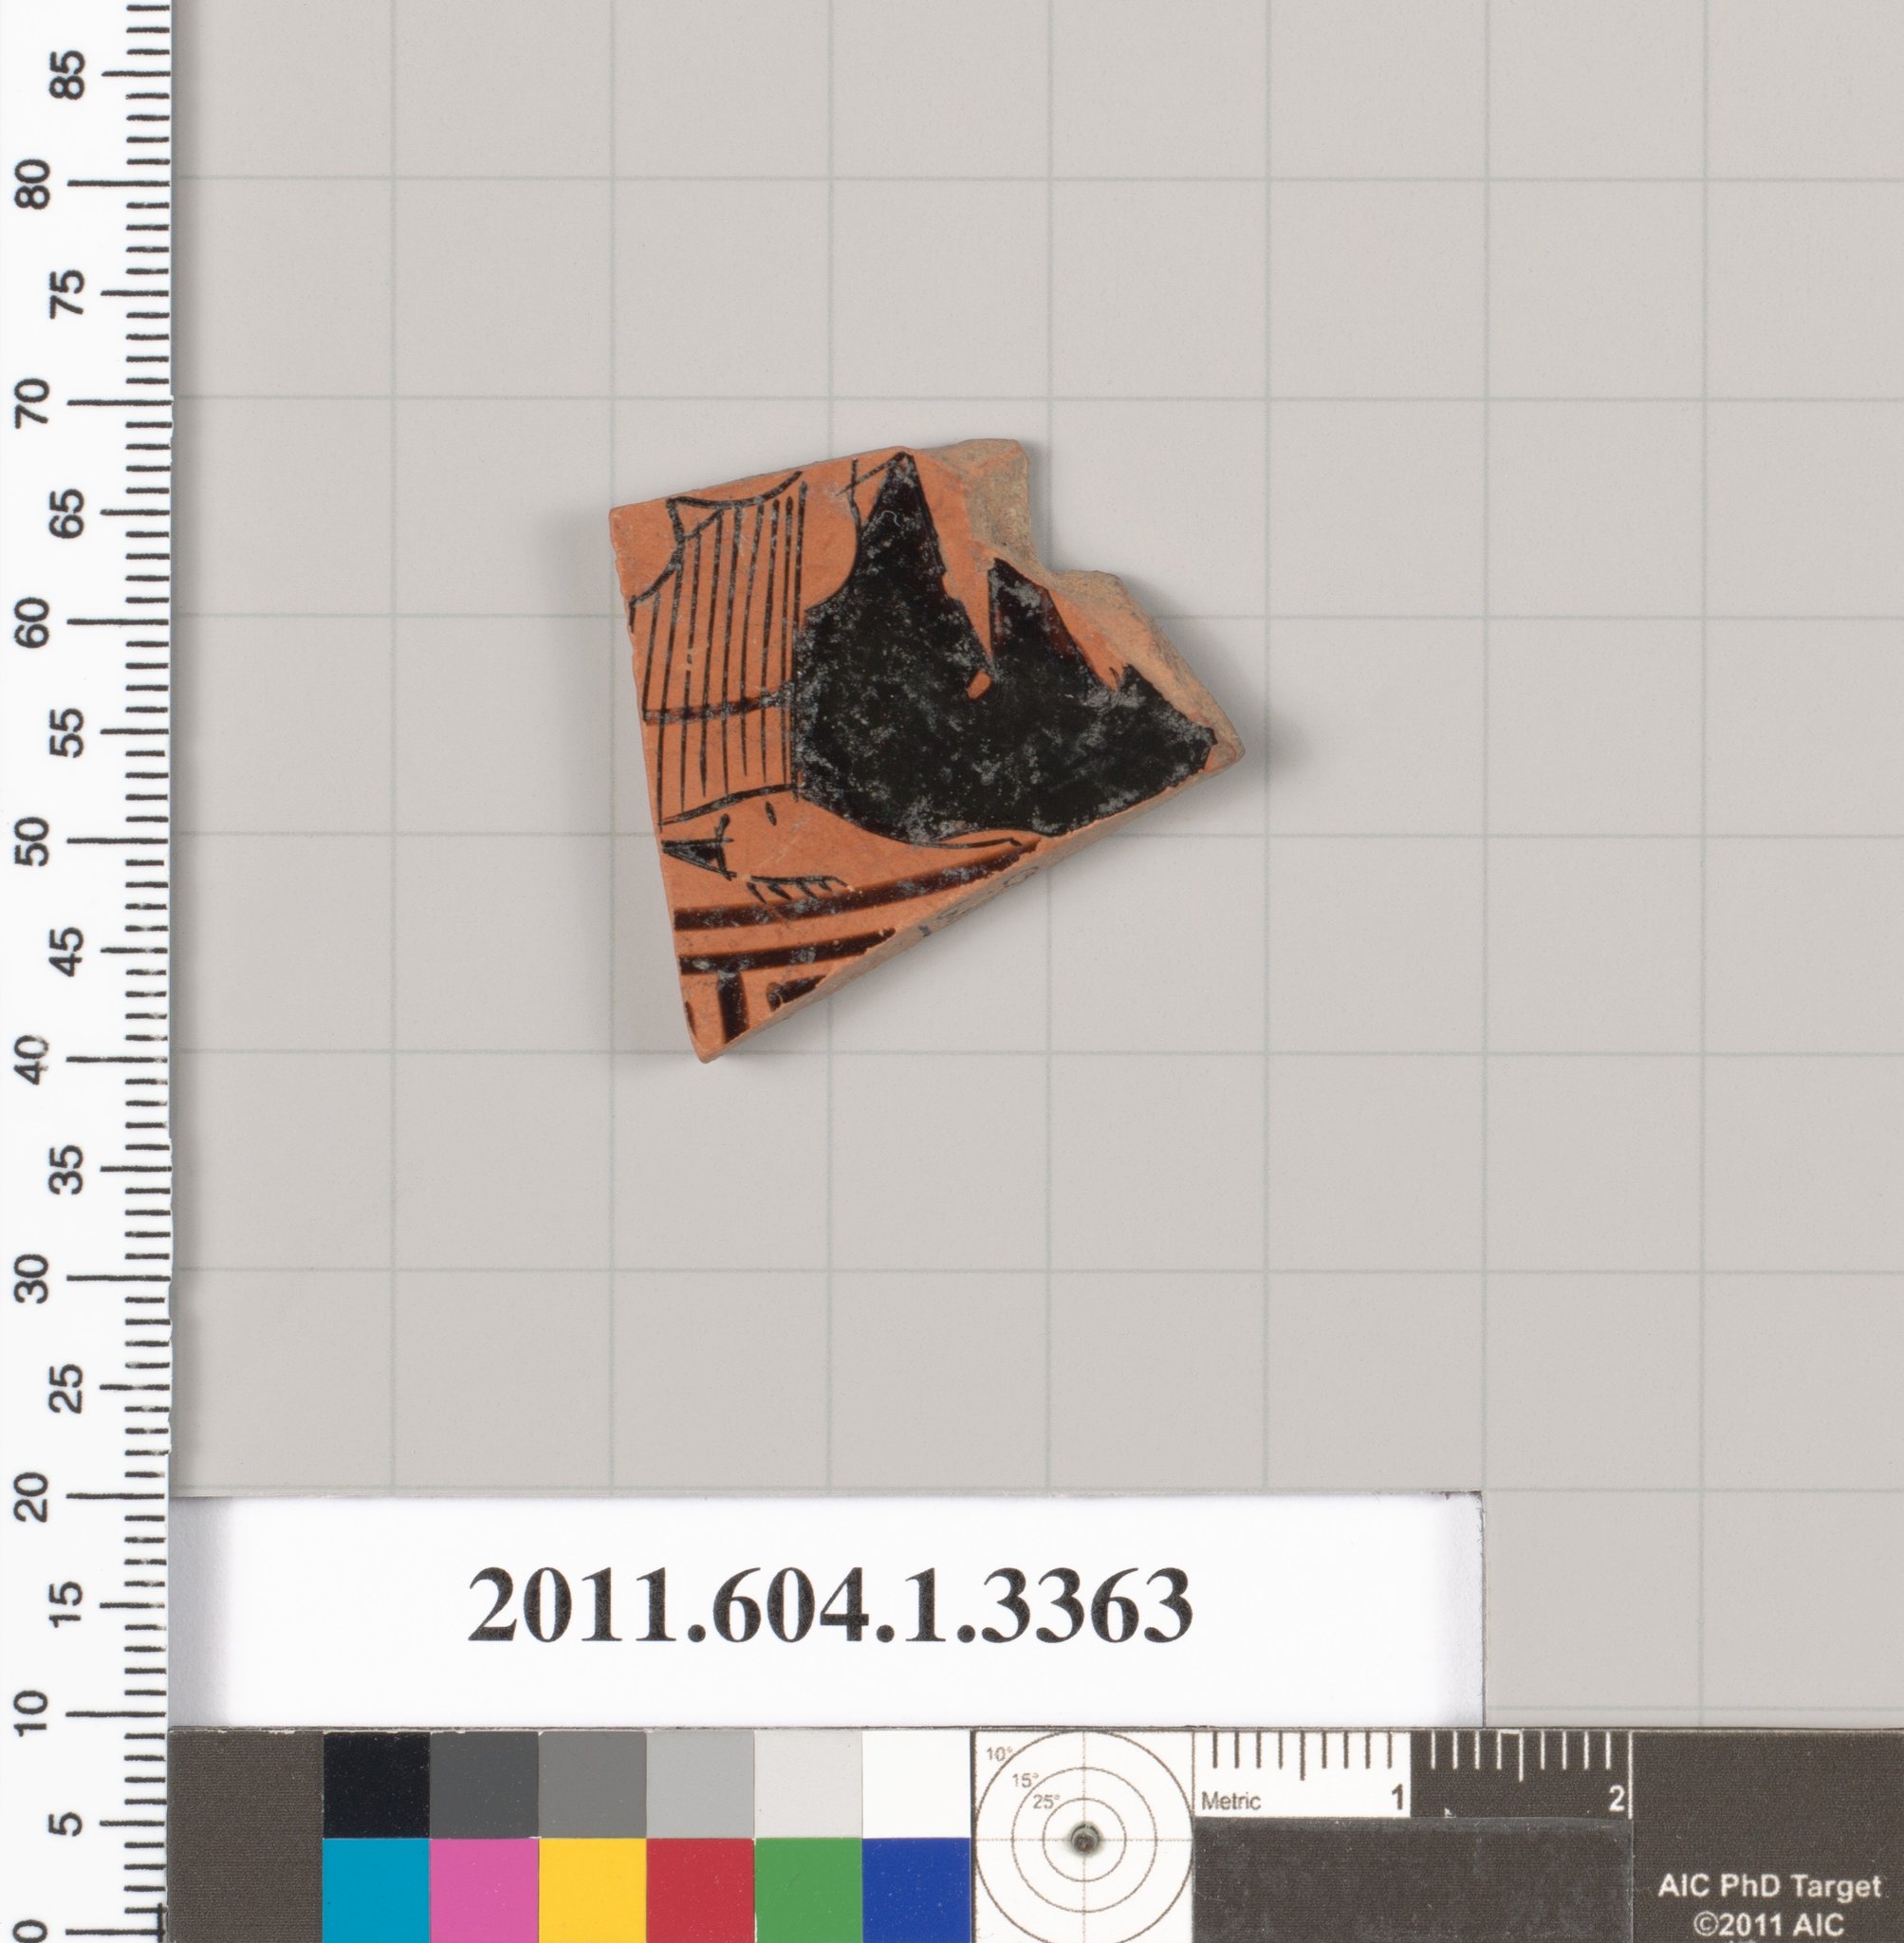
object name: kylix fragment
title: Terracotta fragment of a kylix (drinking cup)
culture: greek, attic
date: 480-470 BCE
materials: terracotta